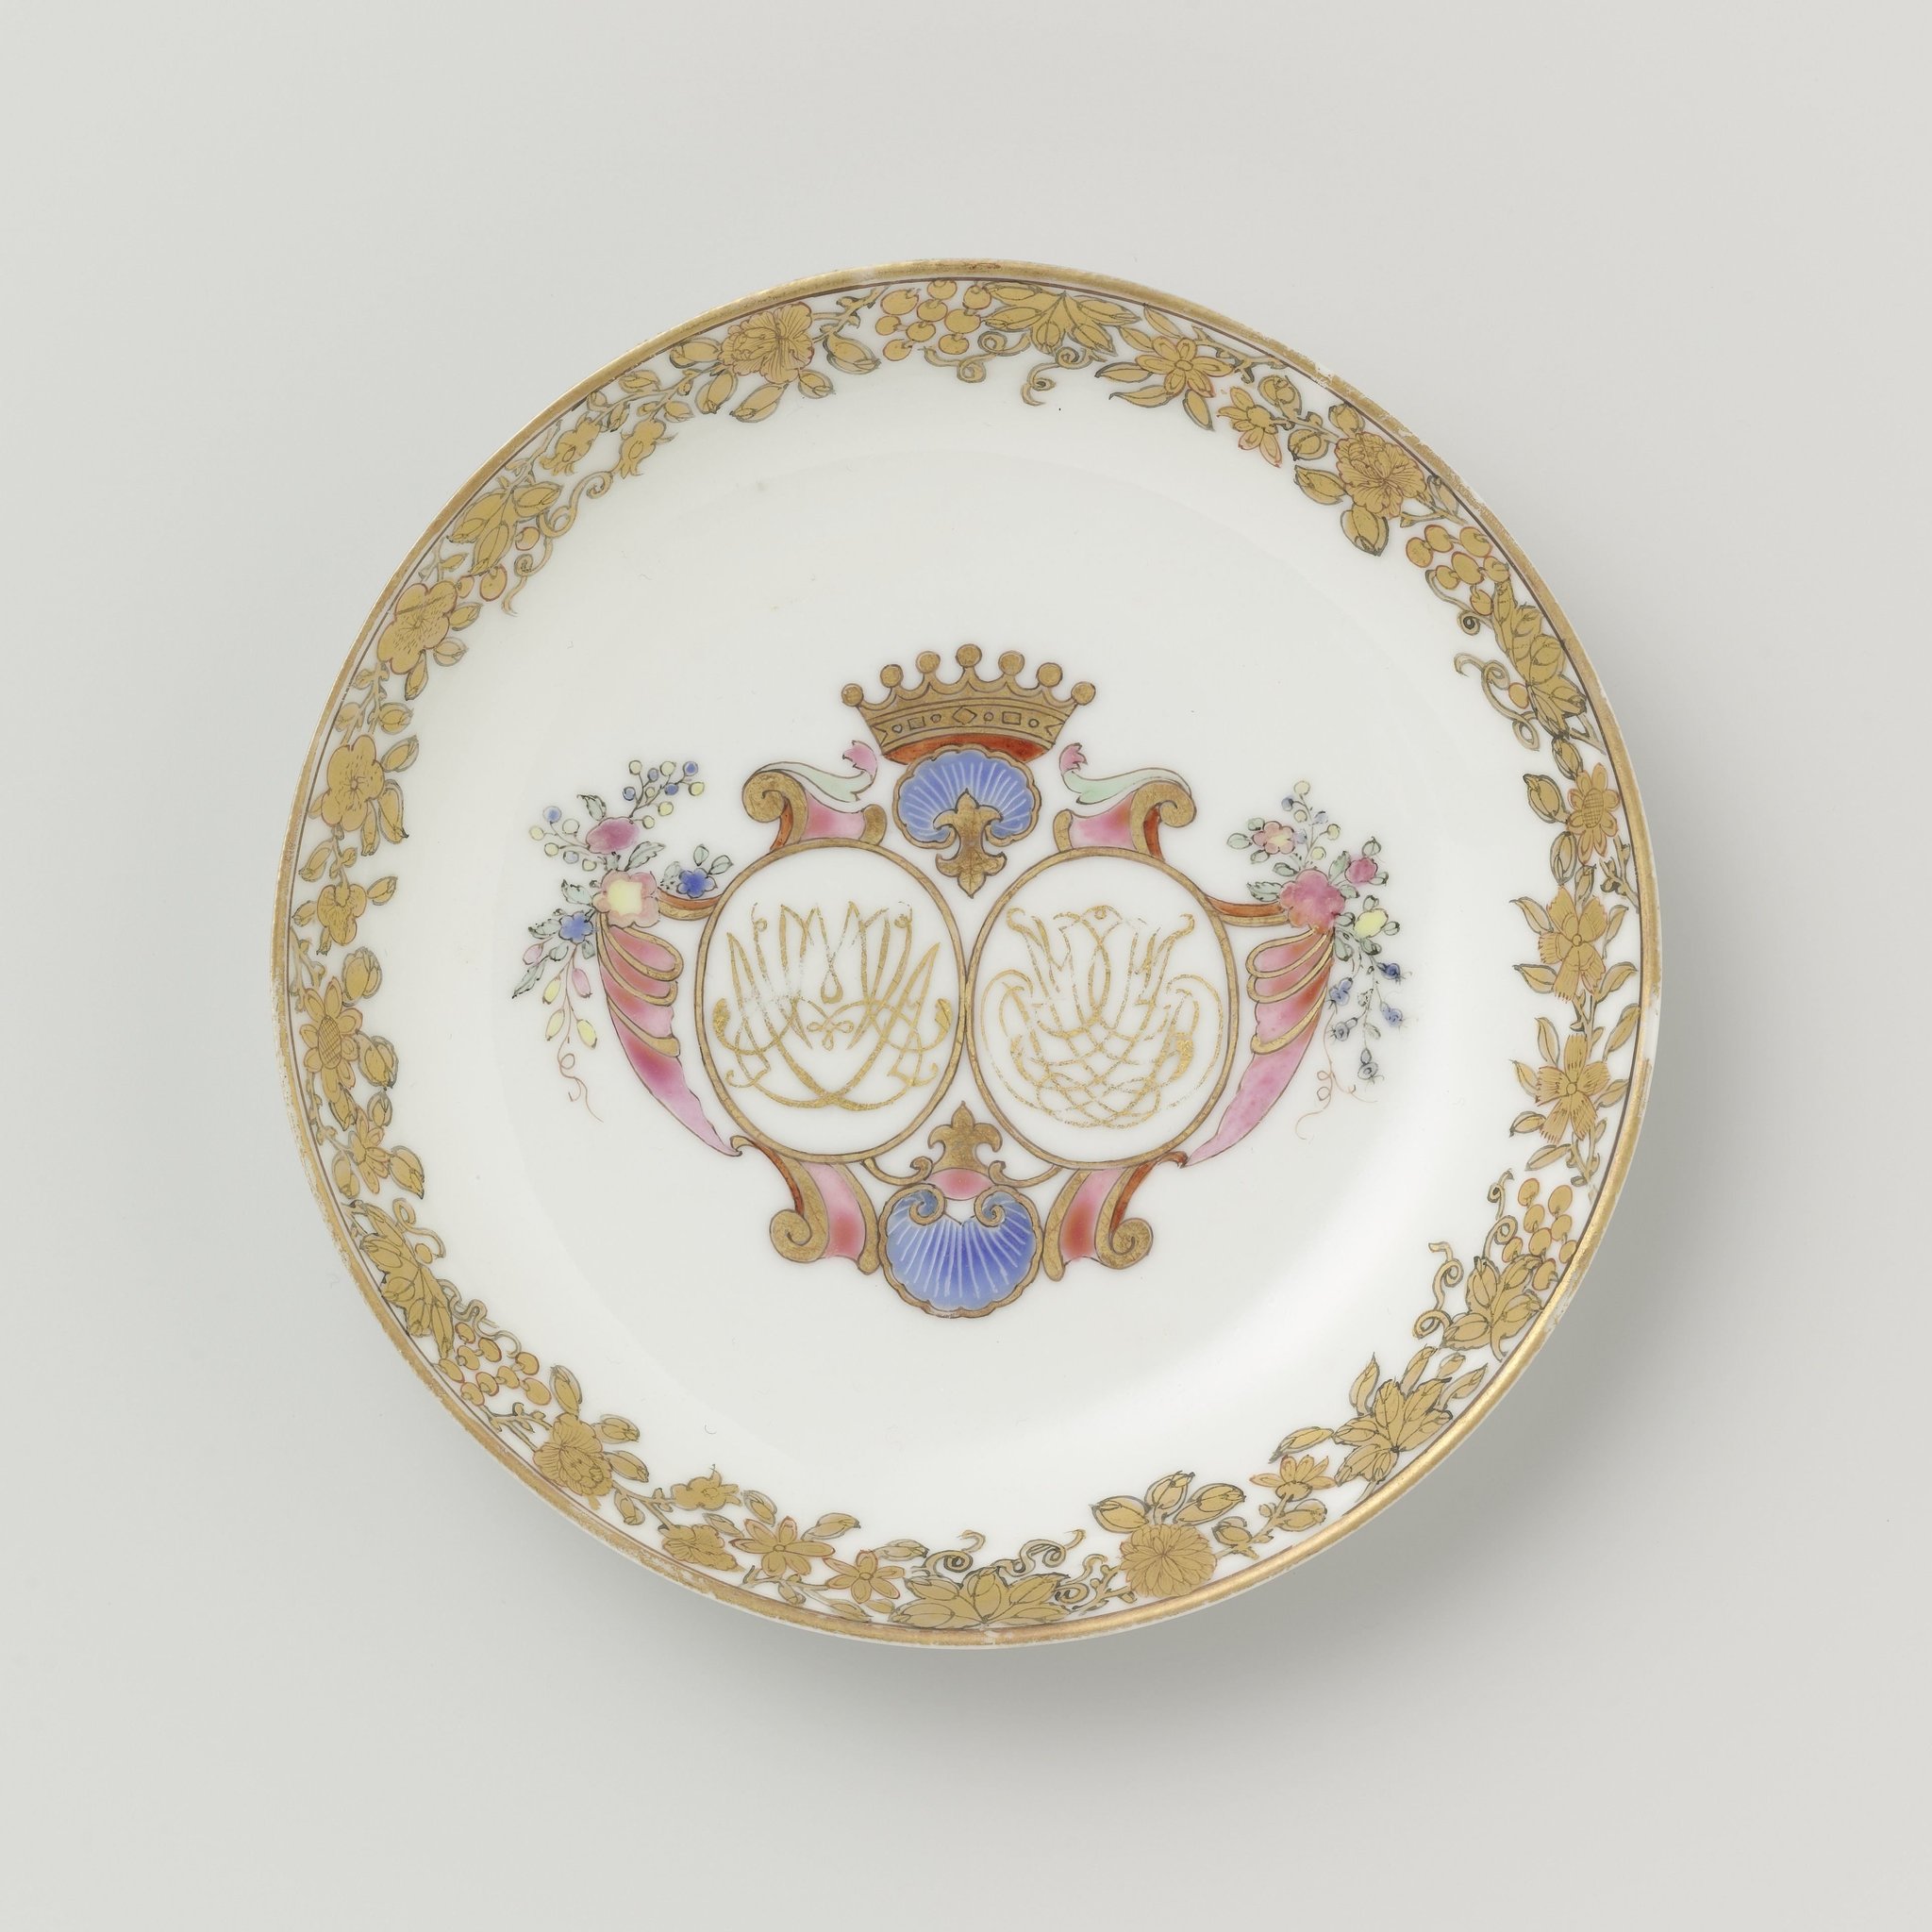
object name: platter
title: Saucer from the 'Swellengrebel service' with a double crowned monogram and a border with floral scrolls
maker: Anonymous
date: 1740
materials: glaze, gold, paint, porcelain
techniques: firing, gilding, turning, vitrification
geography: china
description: De monogrammen 'MVA' en 'CHTD' staan voor Maurits van Aerden (1694-1746) en Constantia Helena ten Damme (1694-1772), getrouwd in 1716. Het servies is waarschijnlijk besteld ter ere van hun vijfentwingtigjarig huwelijksjubileum in 1741. (Campen, Jan van & Hartkamp-Jonxis, Ebeltje, Aziatische weelde : VOC-kunst in het Rijksmuseum, Zutphen 2011, p. 78)